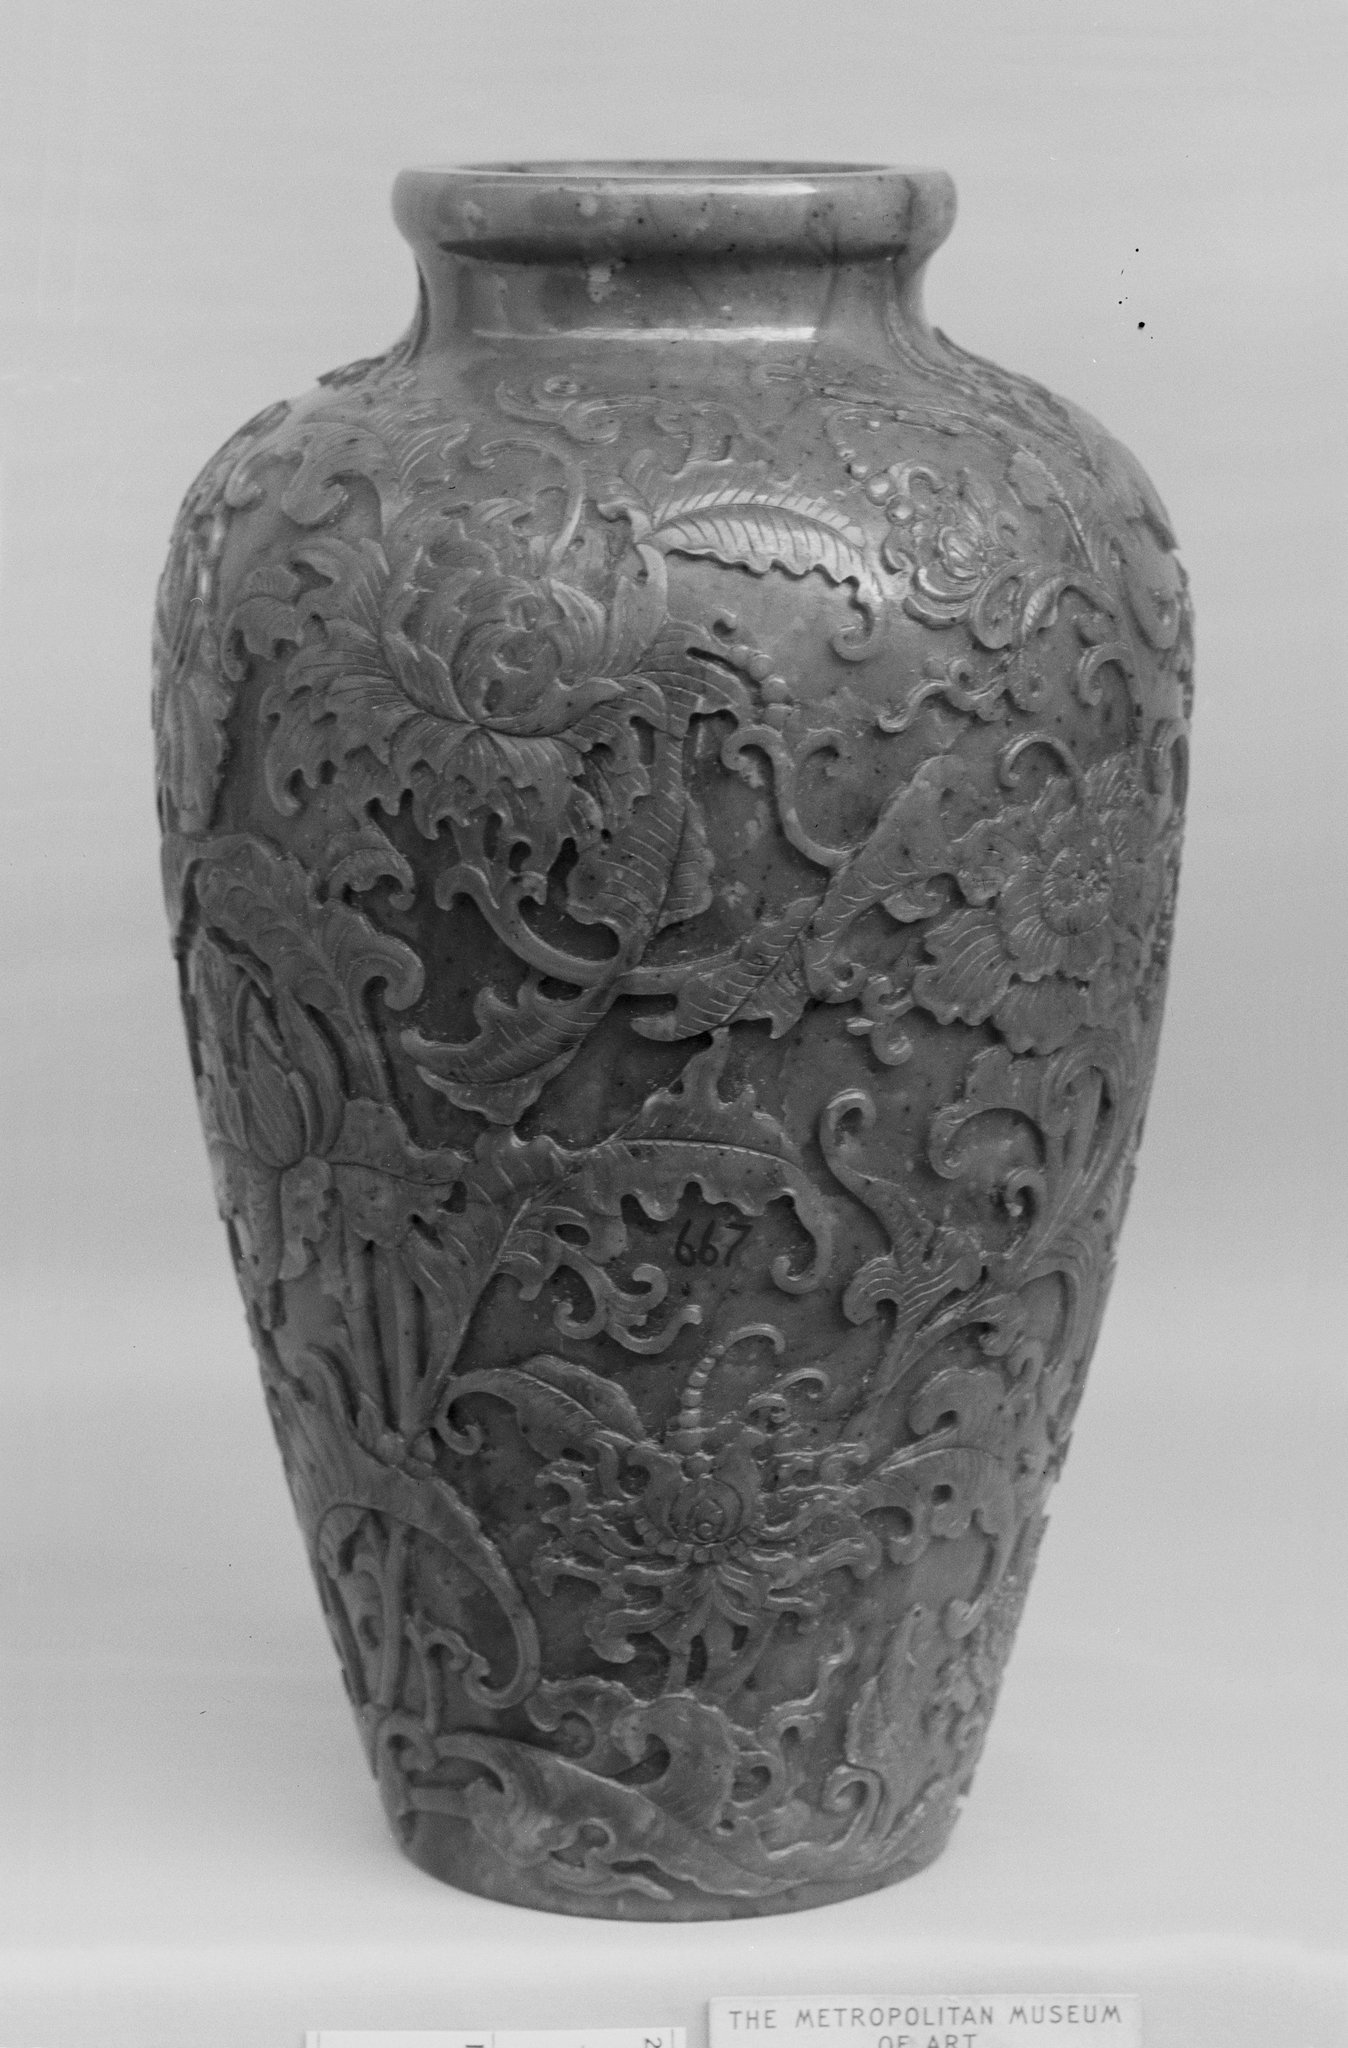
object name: vase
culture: chinese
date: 1701-1900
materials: jade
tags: flowers